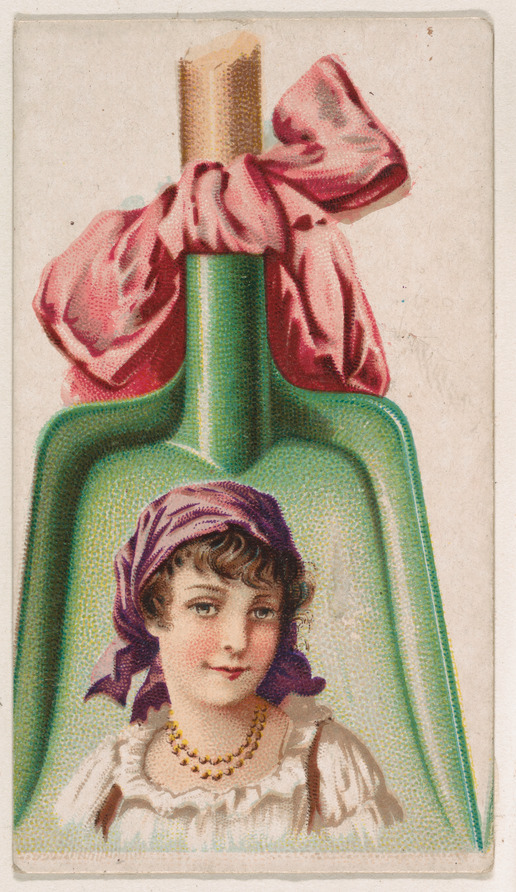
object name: print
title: Shovel, from the Novelties series (N228, Type 5) issued by Kinney Bros.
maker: kinney brothers tobacco company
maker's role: publisher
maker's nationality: american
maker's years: 1869-2011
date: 1889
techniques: color lithograph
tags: women,tools